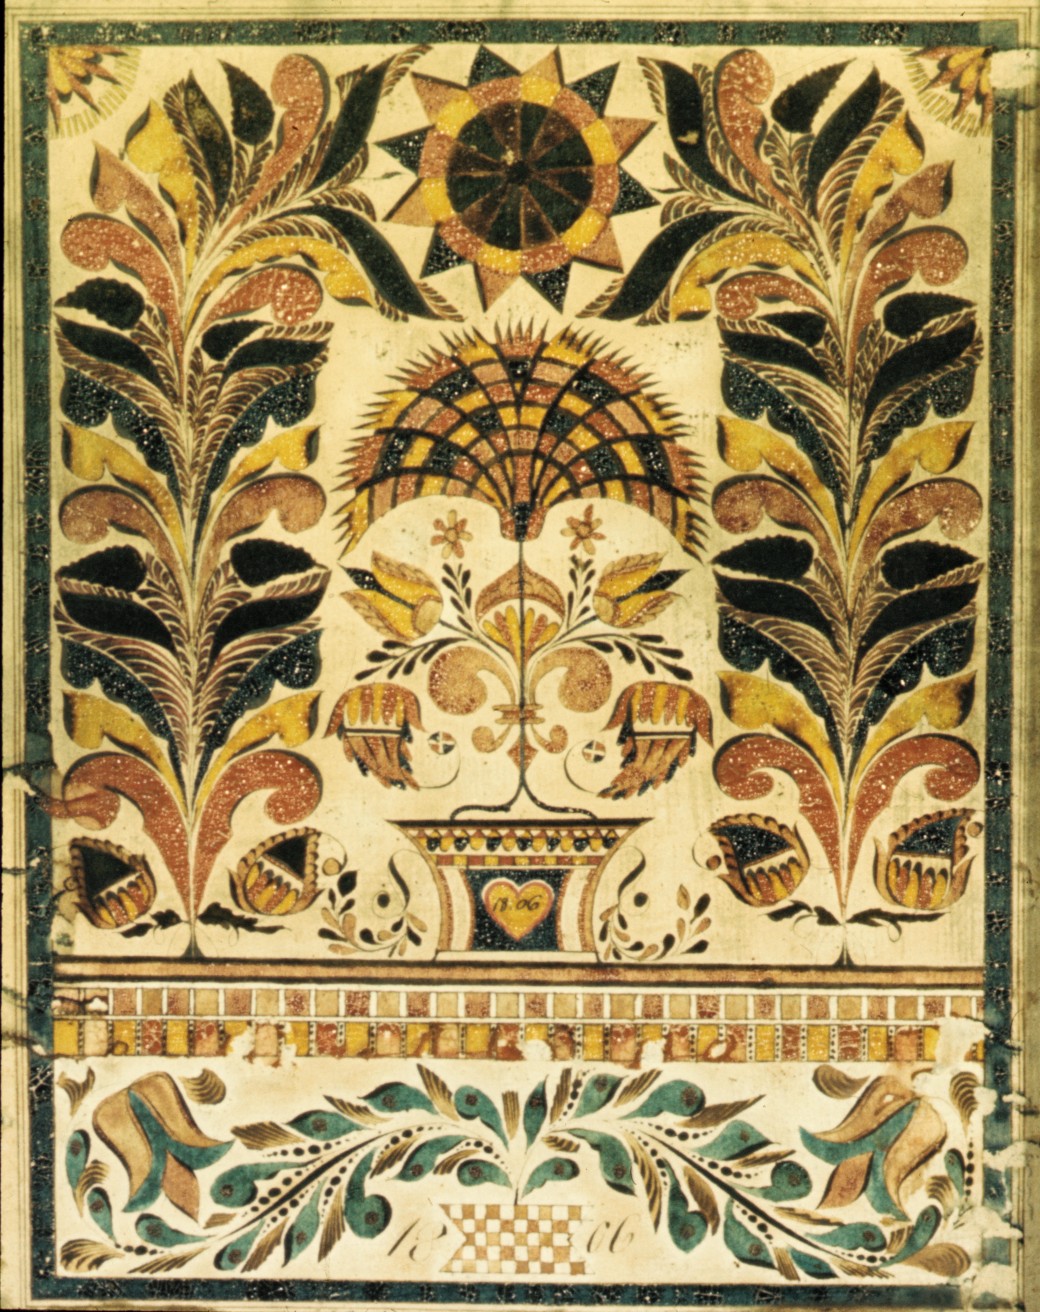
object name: flyleaf, fraktur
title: Flyleaf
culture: american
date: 1806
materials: ink, paper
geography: united states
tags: flowers,leaves